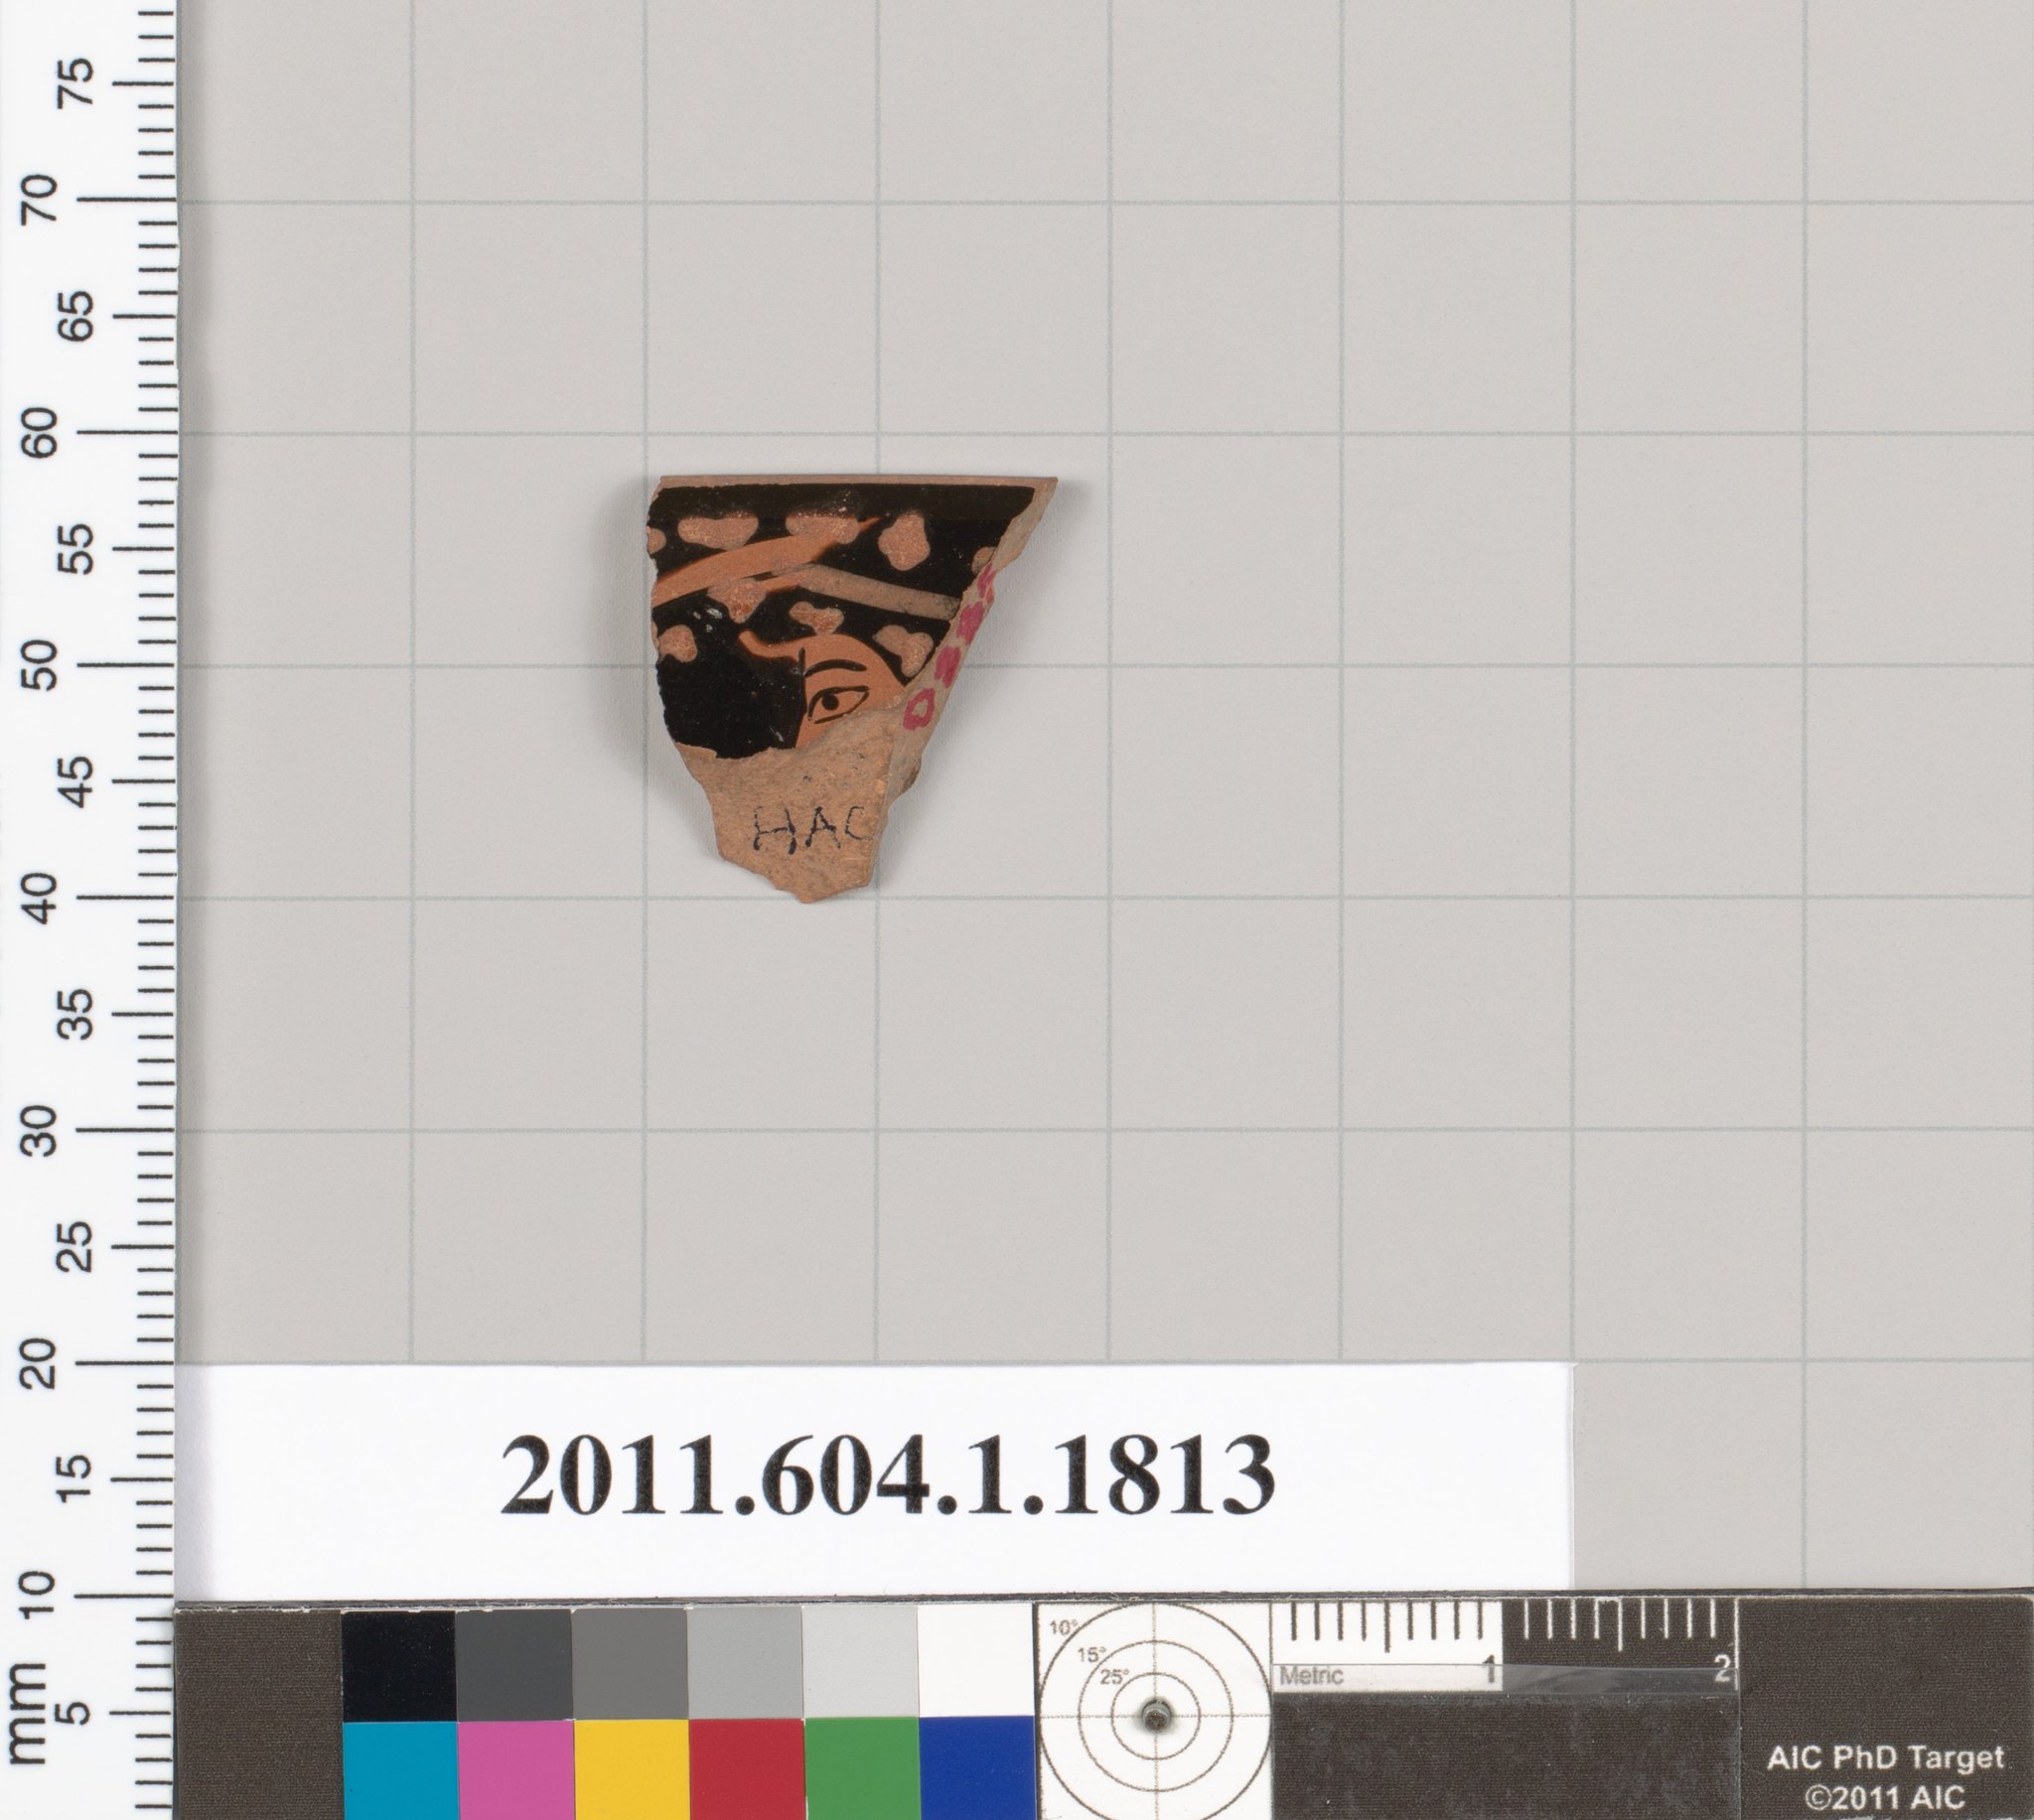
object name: kylix fragment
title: Terracotta rim fragment of a kylix (drinking cup)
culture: greek, attic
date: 490-480 BCE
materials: terracotta